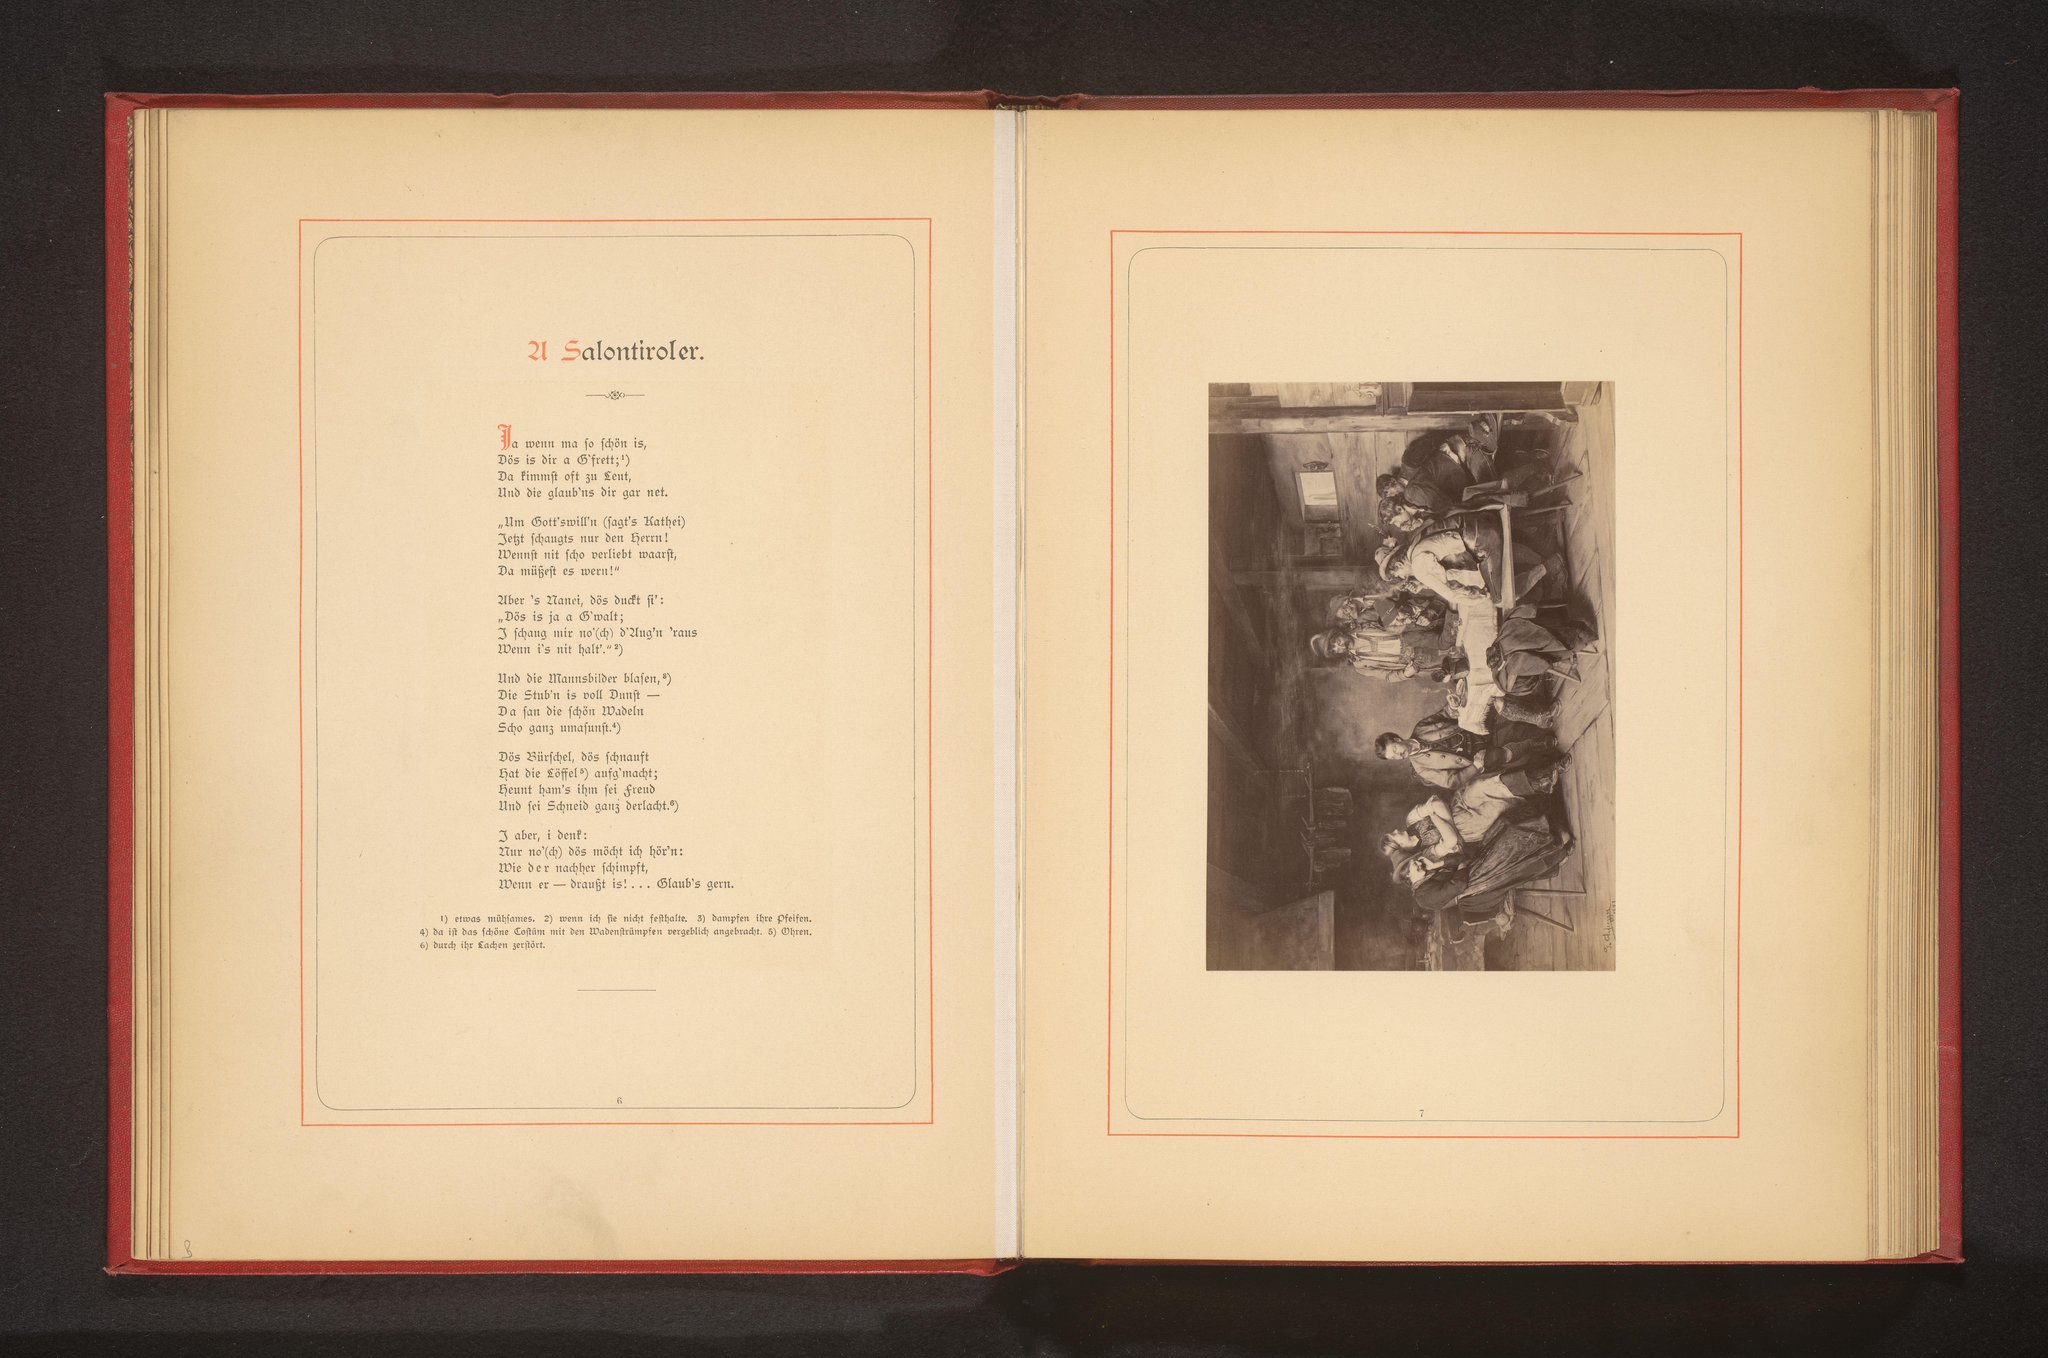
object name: photograph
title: Fotoreproductie van een schilderij, voorstellende een rokend gezelschap rond een tafel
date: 1882-1883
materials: photographic support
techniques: albumen print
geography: germany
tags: table, interior ~ representation of a building, tobacco